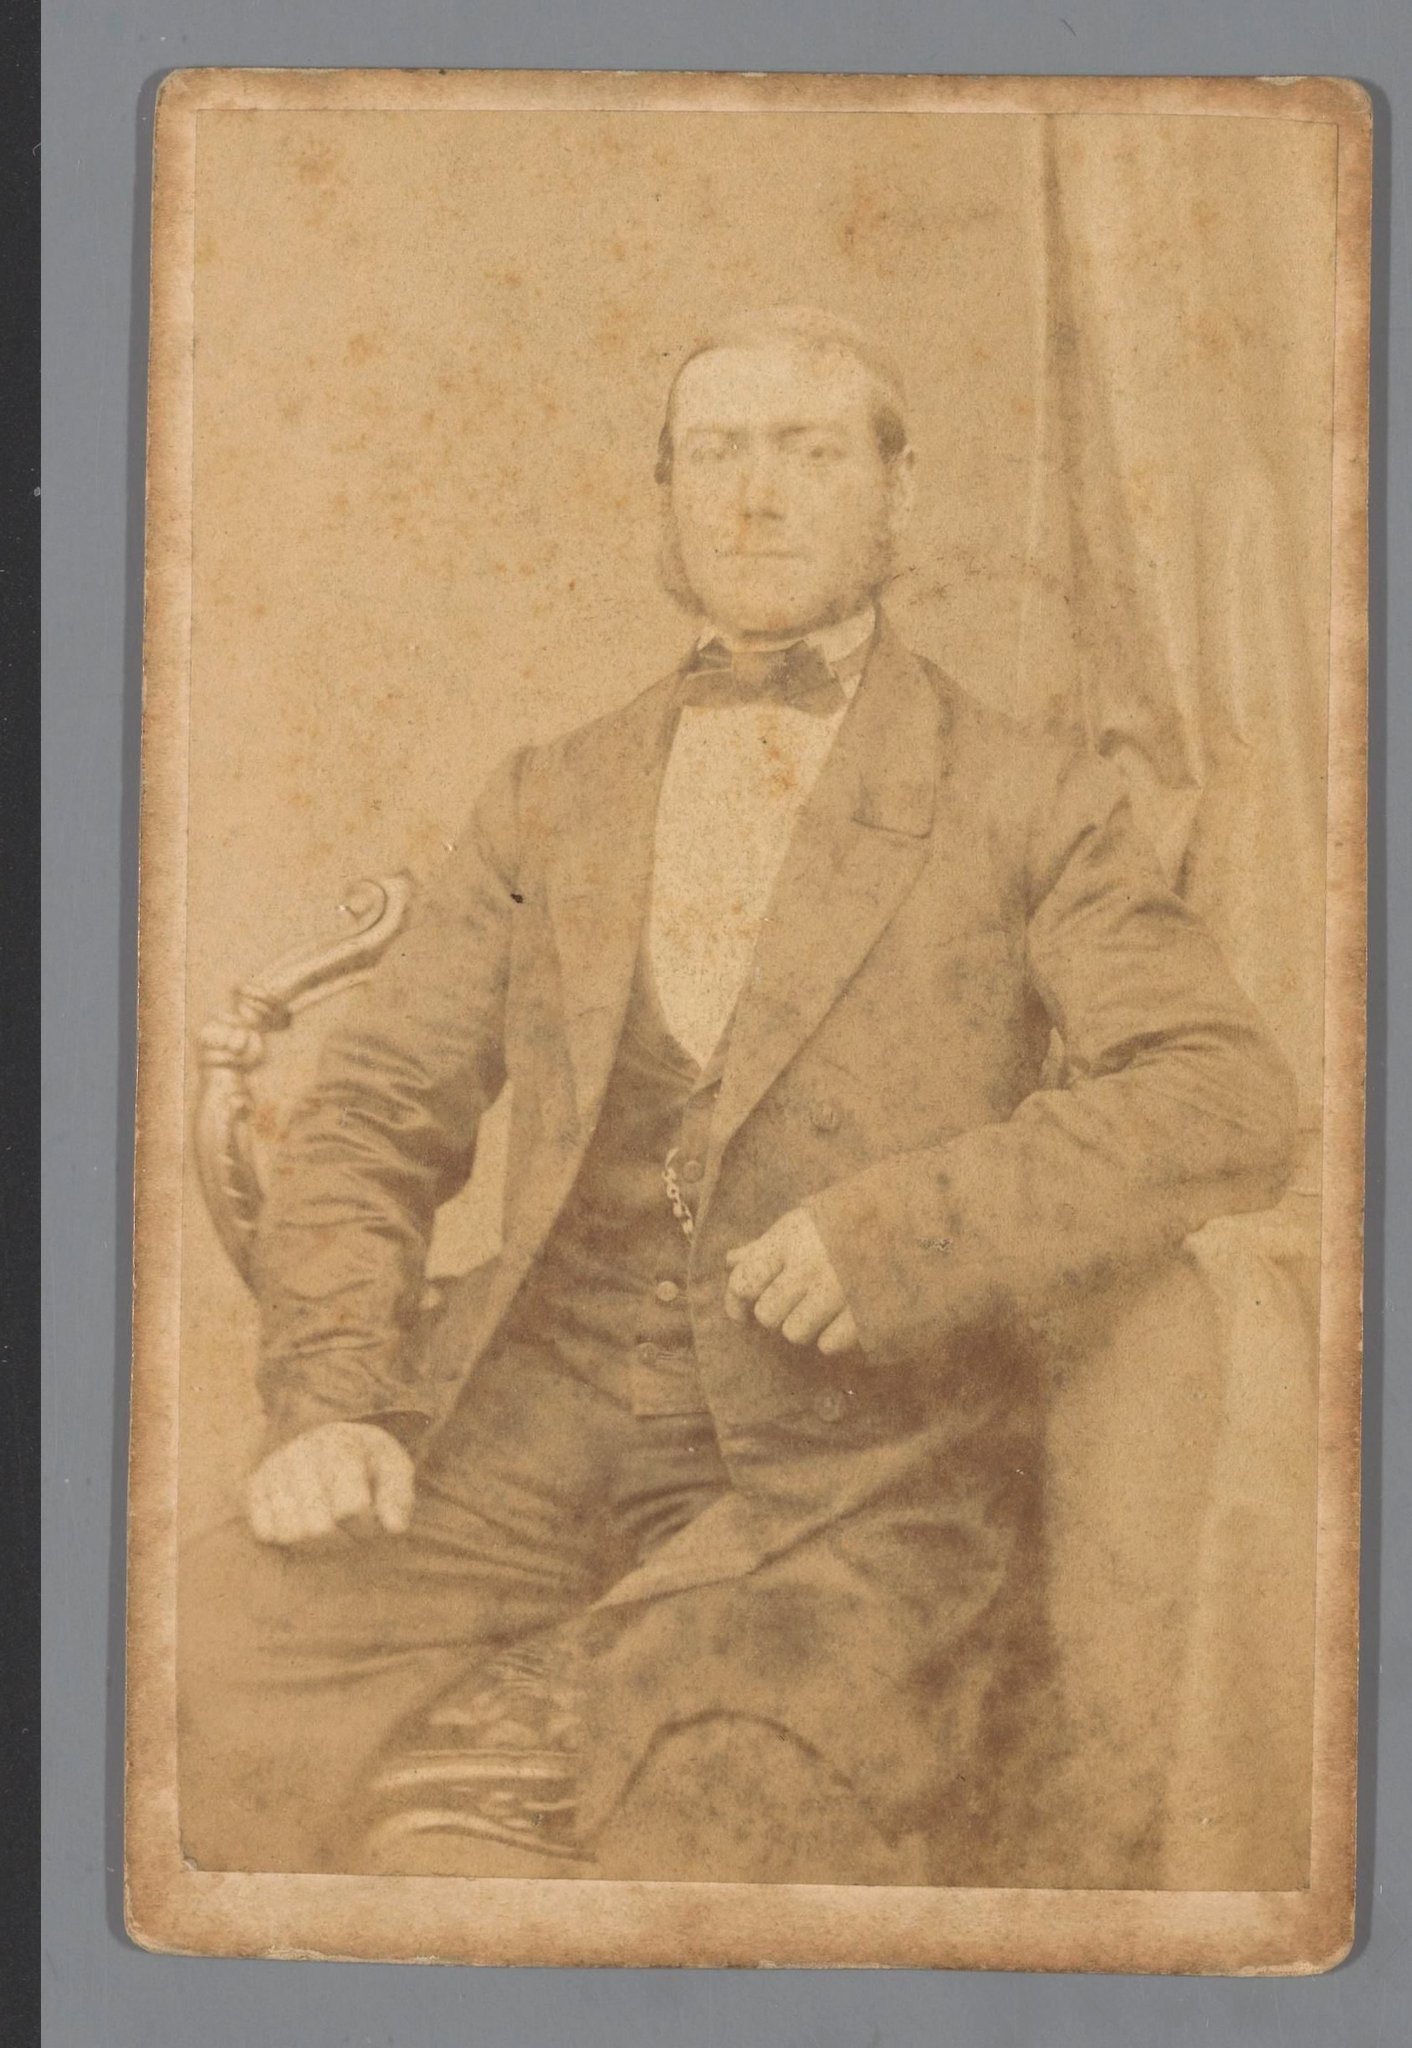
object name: photograph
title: Portret van een man met bakkebaarden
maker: franz wilhelm deutmann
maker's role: fotograaf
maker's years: 1809-1895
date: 1860-1880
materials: cardboard, paper, photographic support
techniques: albumen print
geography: amsterdam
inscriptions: address: ‘F,W. DEUTMANN // PHOTOGRAPH // AMSTERDAM.’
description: Portret van een zittende man, recht van voren gezien, à trois quart.